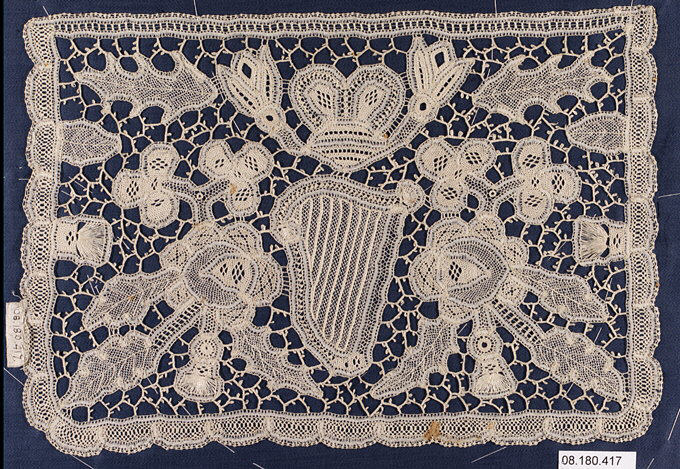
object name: border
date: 1801-1900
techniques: lace